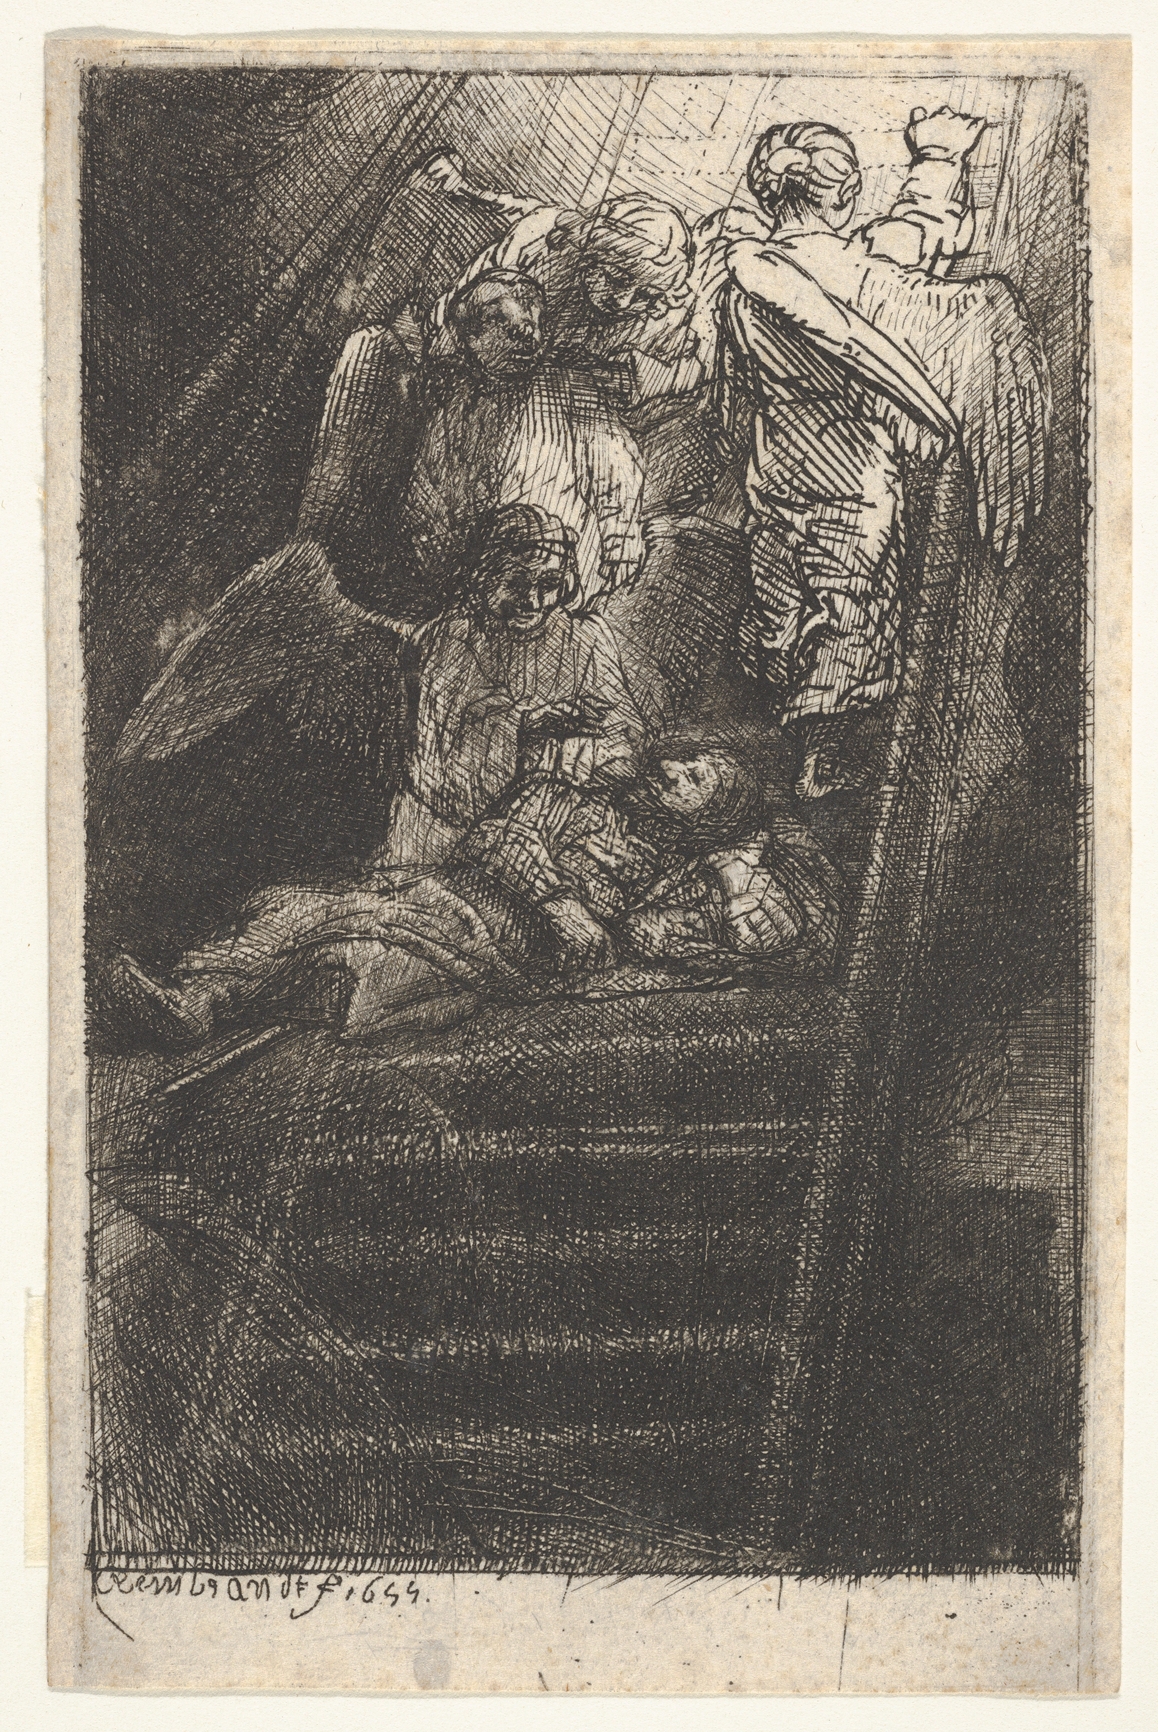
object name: print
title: Jacob's Ladder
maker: rembrandt van rijn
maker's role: artist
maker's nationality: dutch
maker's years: 1606-1669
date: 1655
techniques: engraving, etching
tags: men,ladders